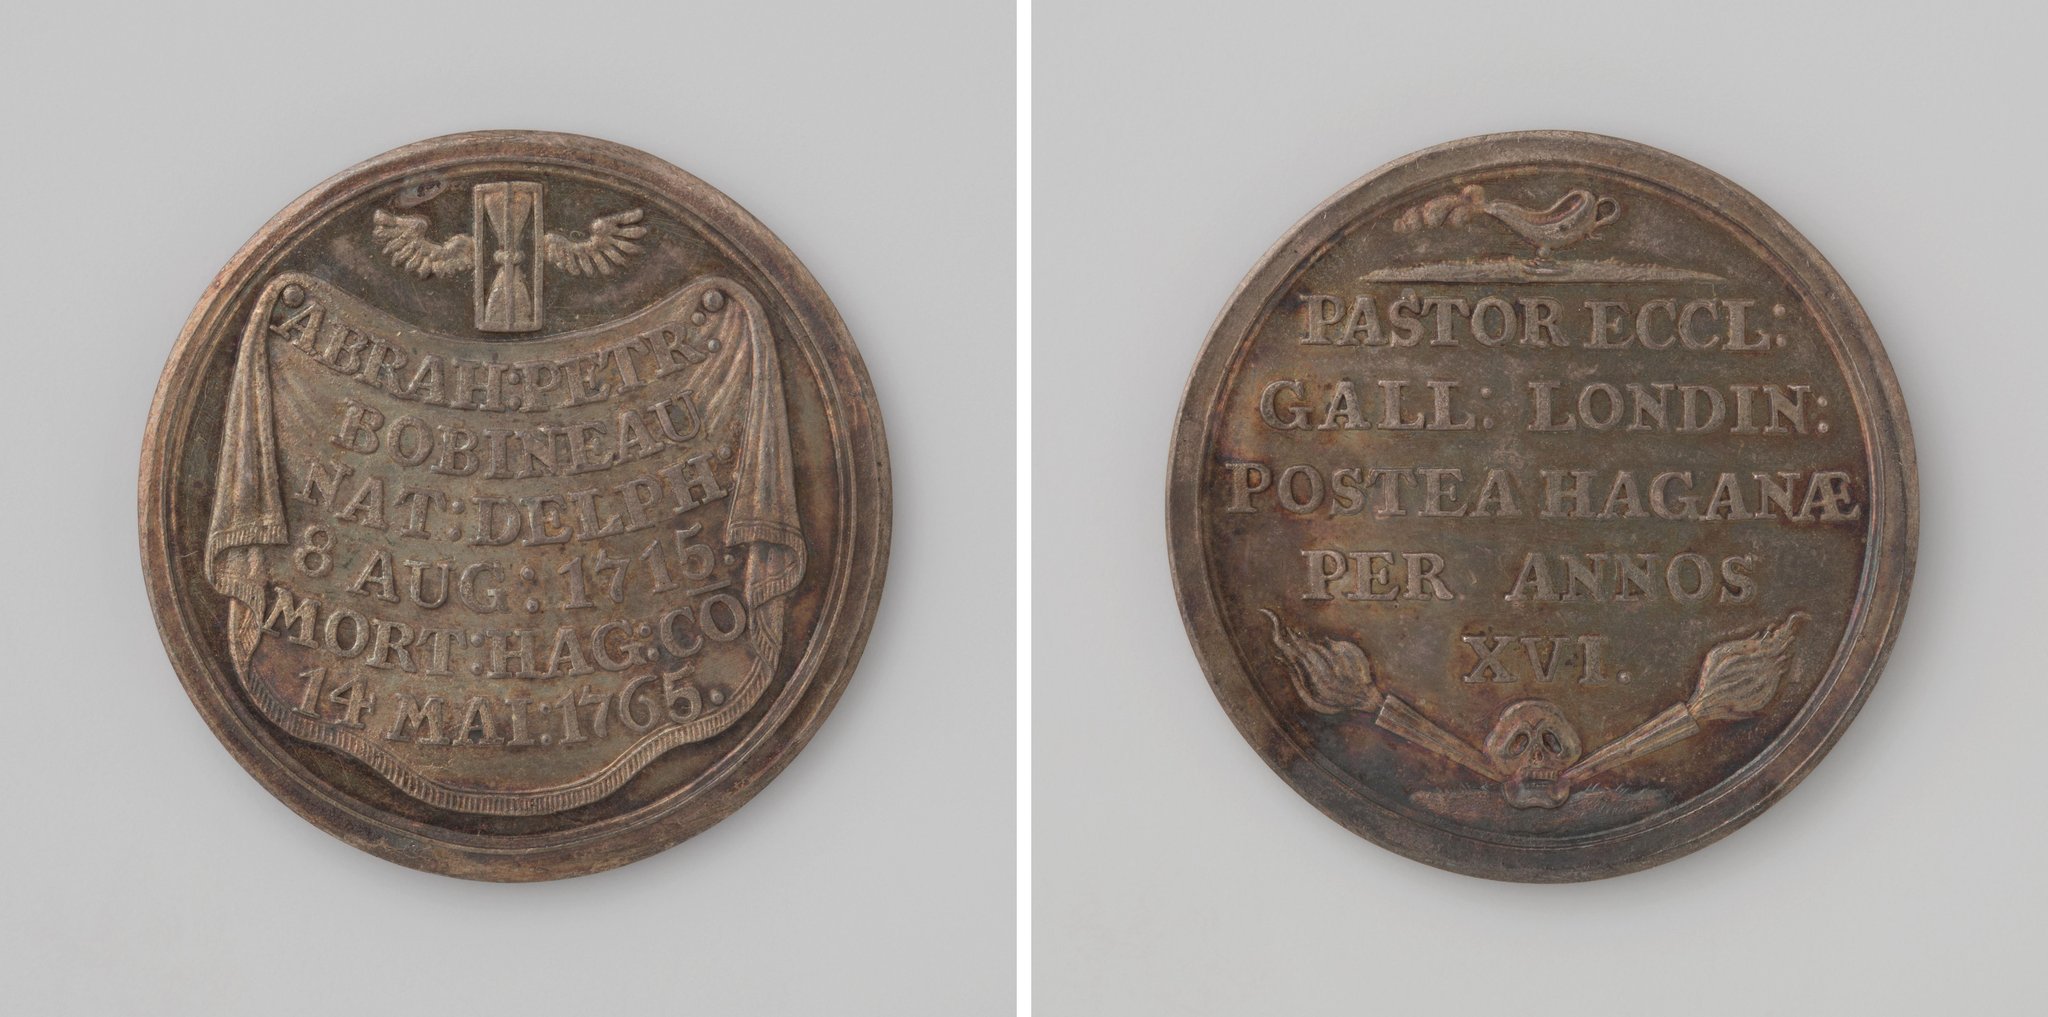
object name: family medal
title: Overlijden van Abraham Pierre Bobineau, Waals predikant te 's-Gravenhage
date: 1765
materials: silver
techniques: striking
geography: netherlands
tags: the hague, london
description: Zilveren penning. Voorzijde: gevleugelde zandloper boven rouwkleed met opschrift. Keerzijde: walmend olielampje boven opschrift; daaronder doodshoofd, waaruit twee brandende fakkels steken